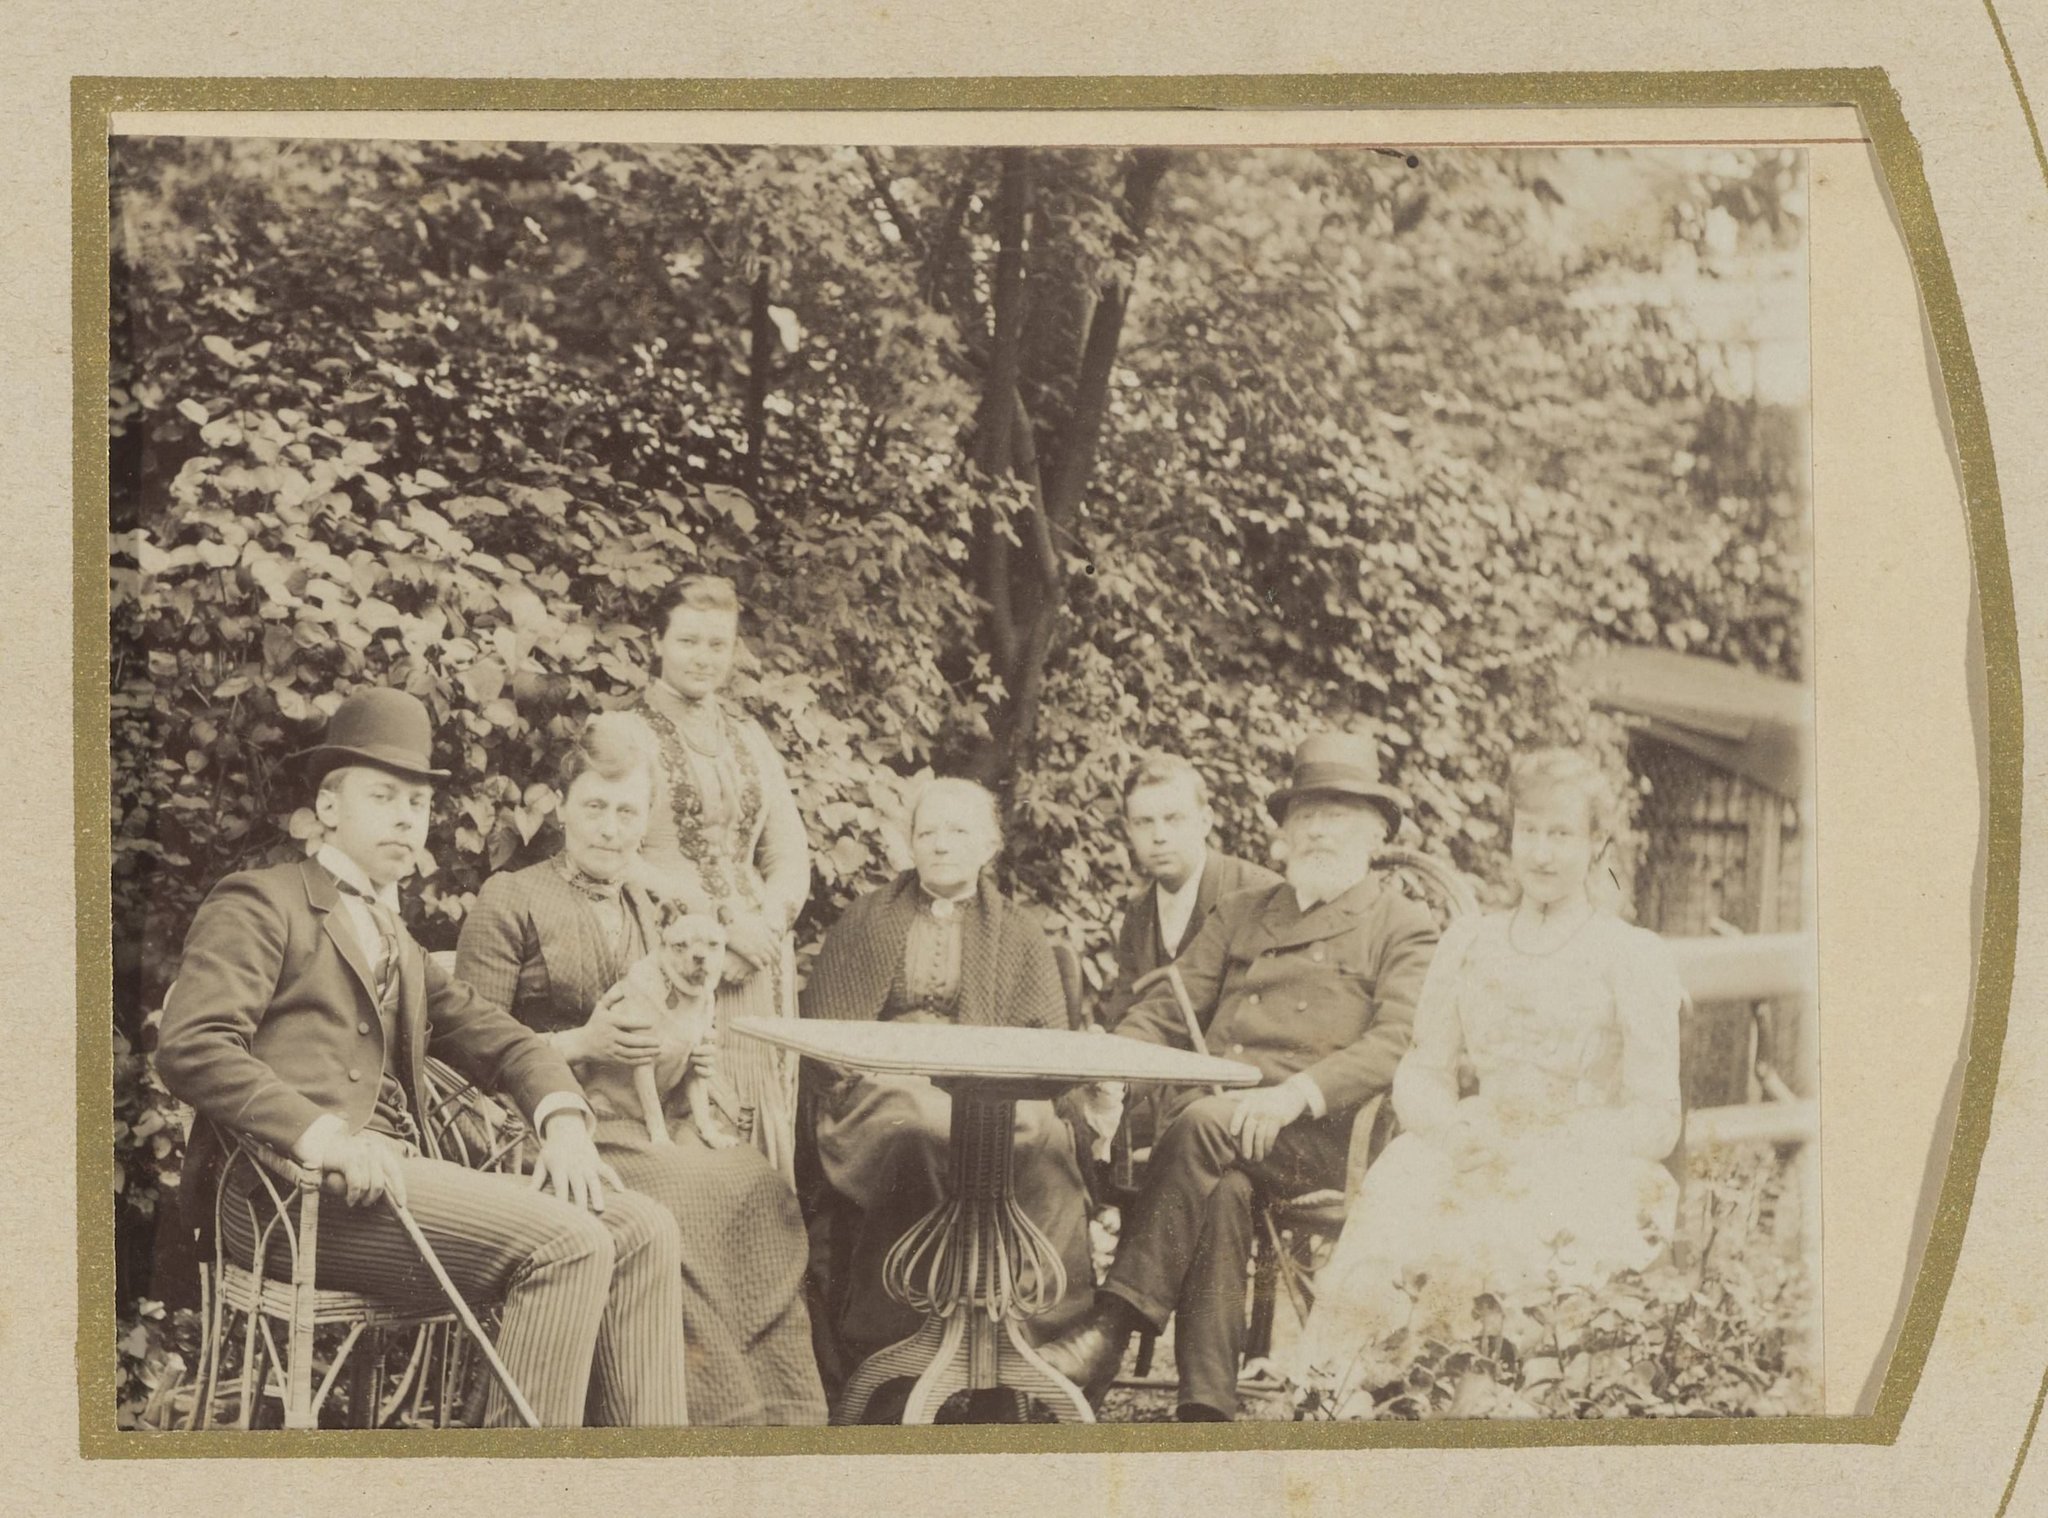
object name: album leaf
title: Portret van een gezin aan een tuintafel met hond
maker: a.th. baert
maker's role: fotograaf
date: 1890-1895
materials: cardboard, photographic support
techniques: albumen print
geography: leiden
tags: garden, dog, anonymous historical persons portrayed in a group, in a group-portrait